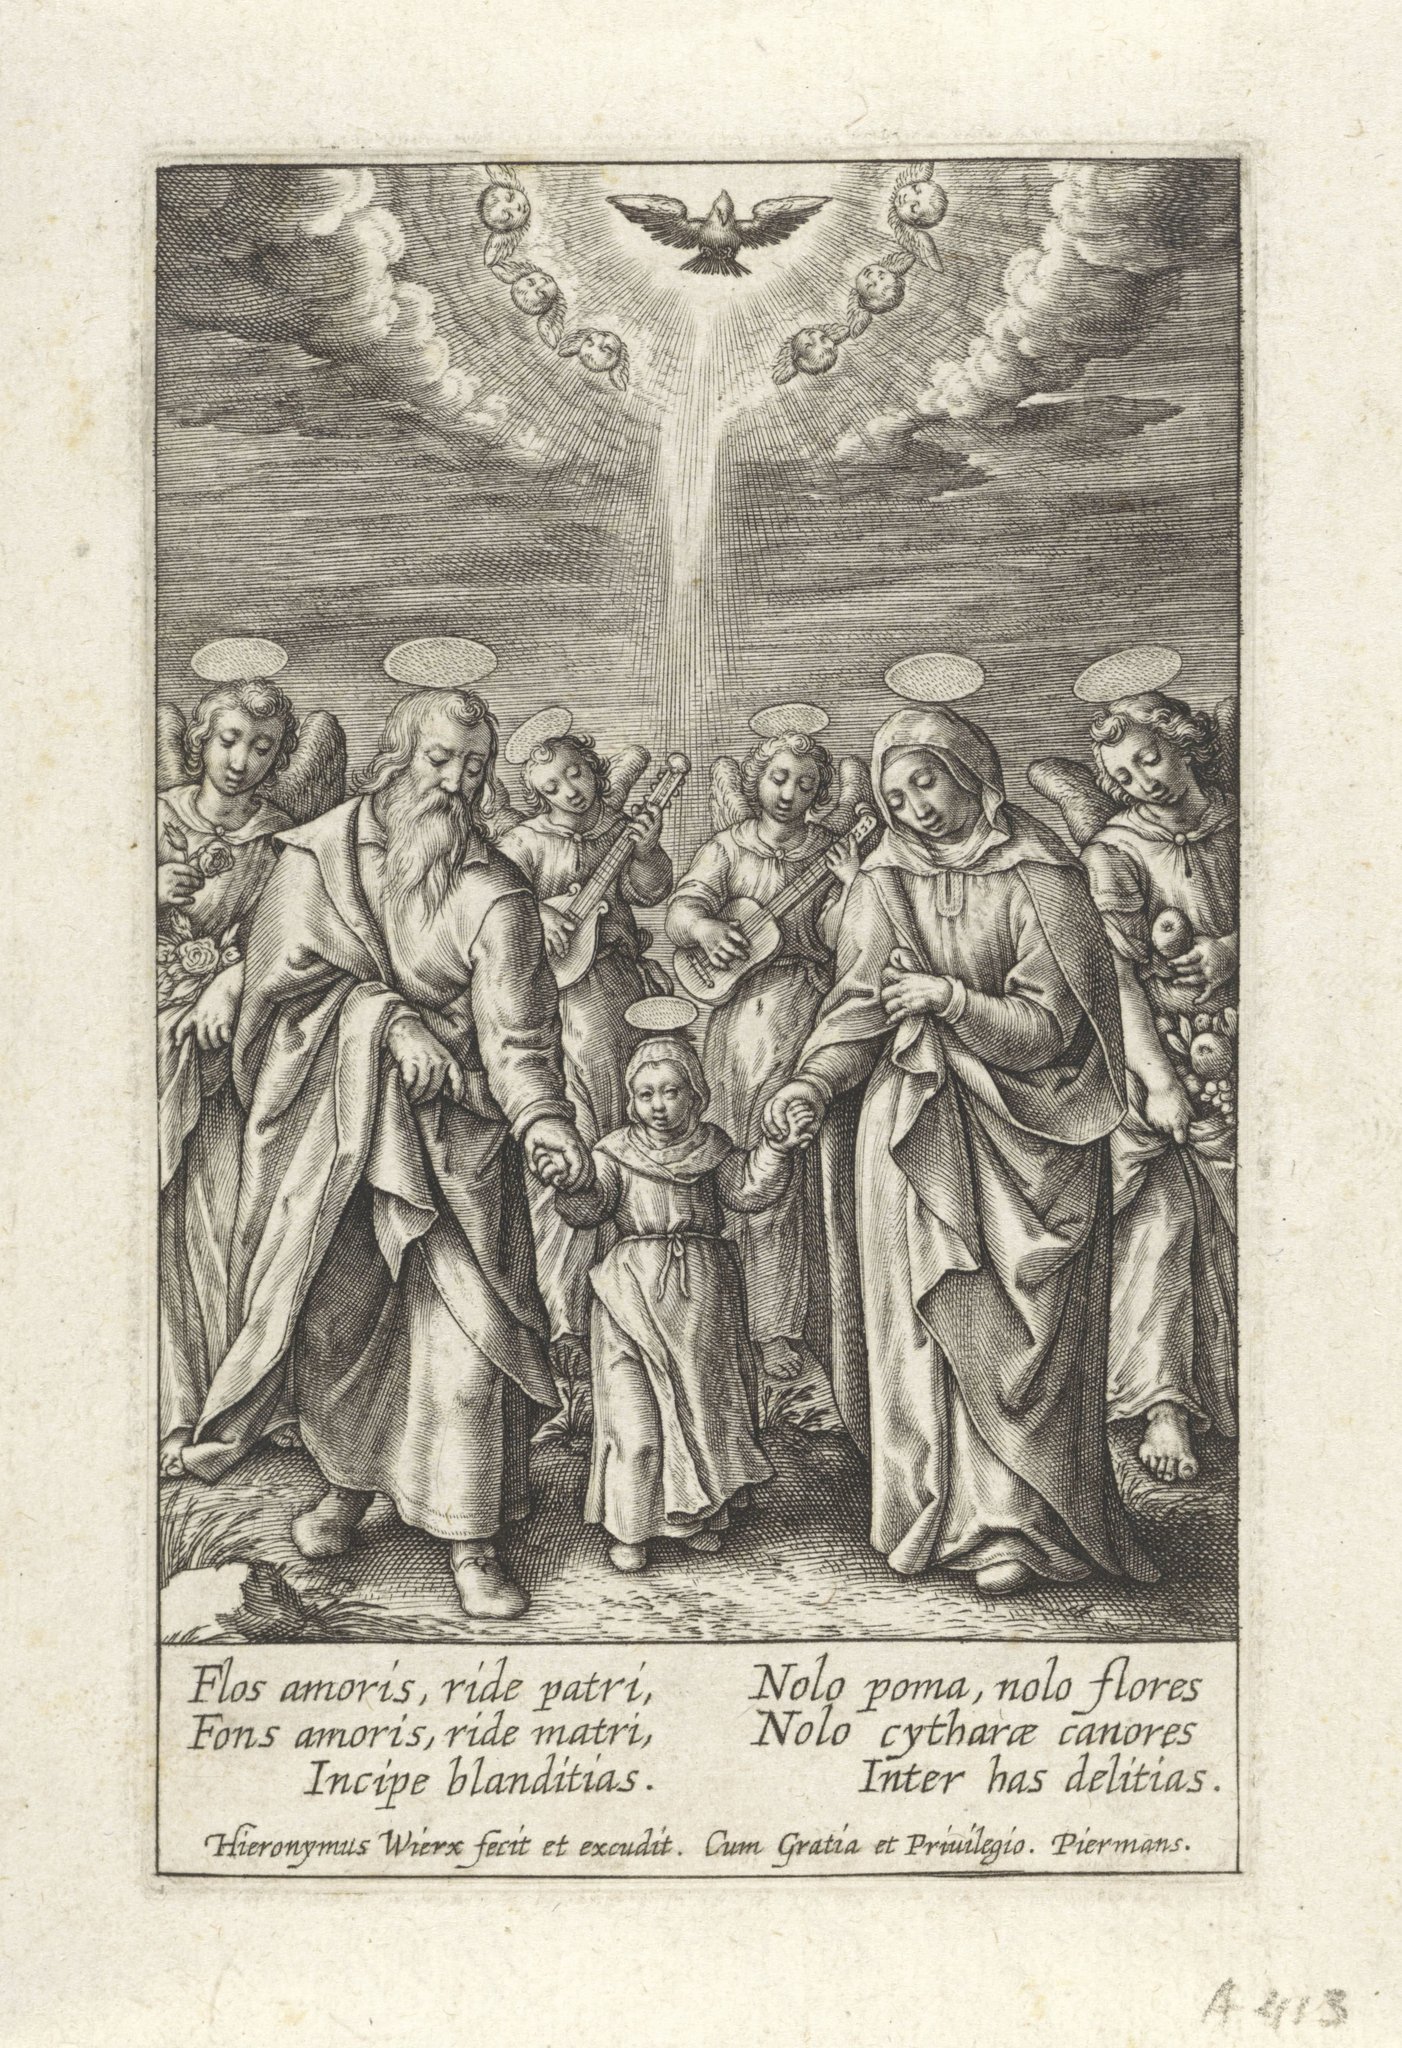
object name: print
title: Leven van de maagd Maria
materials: paper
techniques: engraving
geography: antwerp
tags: devout mary together with her parents; angels, and perhaps god the father present, holy ghost represented as a dove (in flames)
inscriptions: collector's mark: Lugt 2228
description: De jonge Maria loopt, hand in hand, tussen haar ouders Joachim en Anna in. Achter hen musicerende engelen, en sommige met bloemen in de hand. Boven hen de Heilige Geest (als duif), omringd door cherubijnen. In de marge een zesregelig onderschrift, in twee kolommen, in het Latijn.